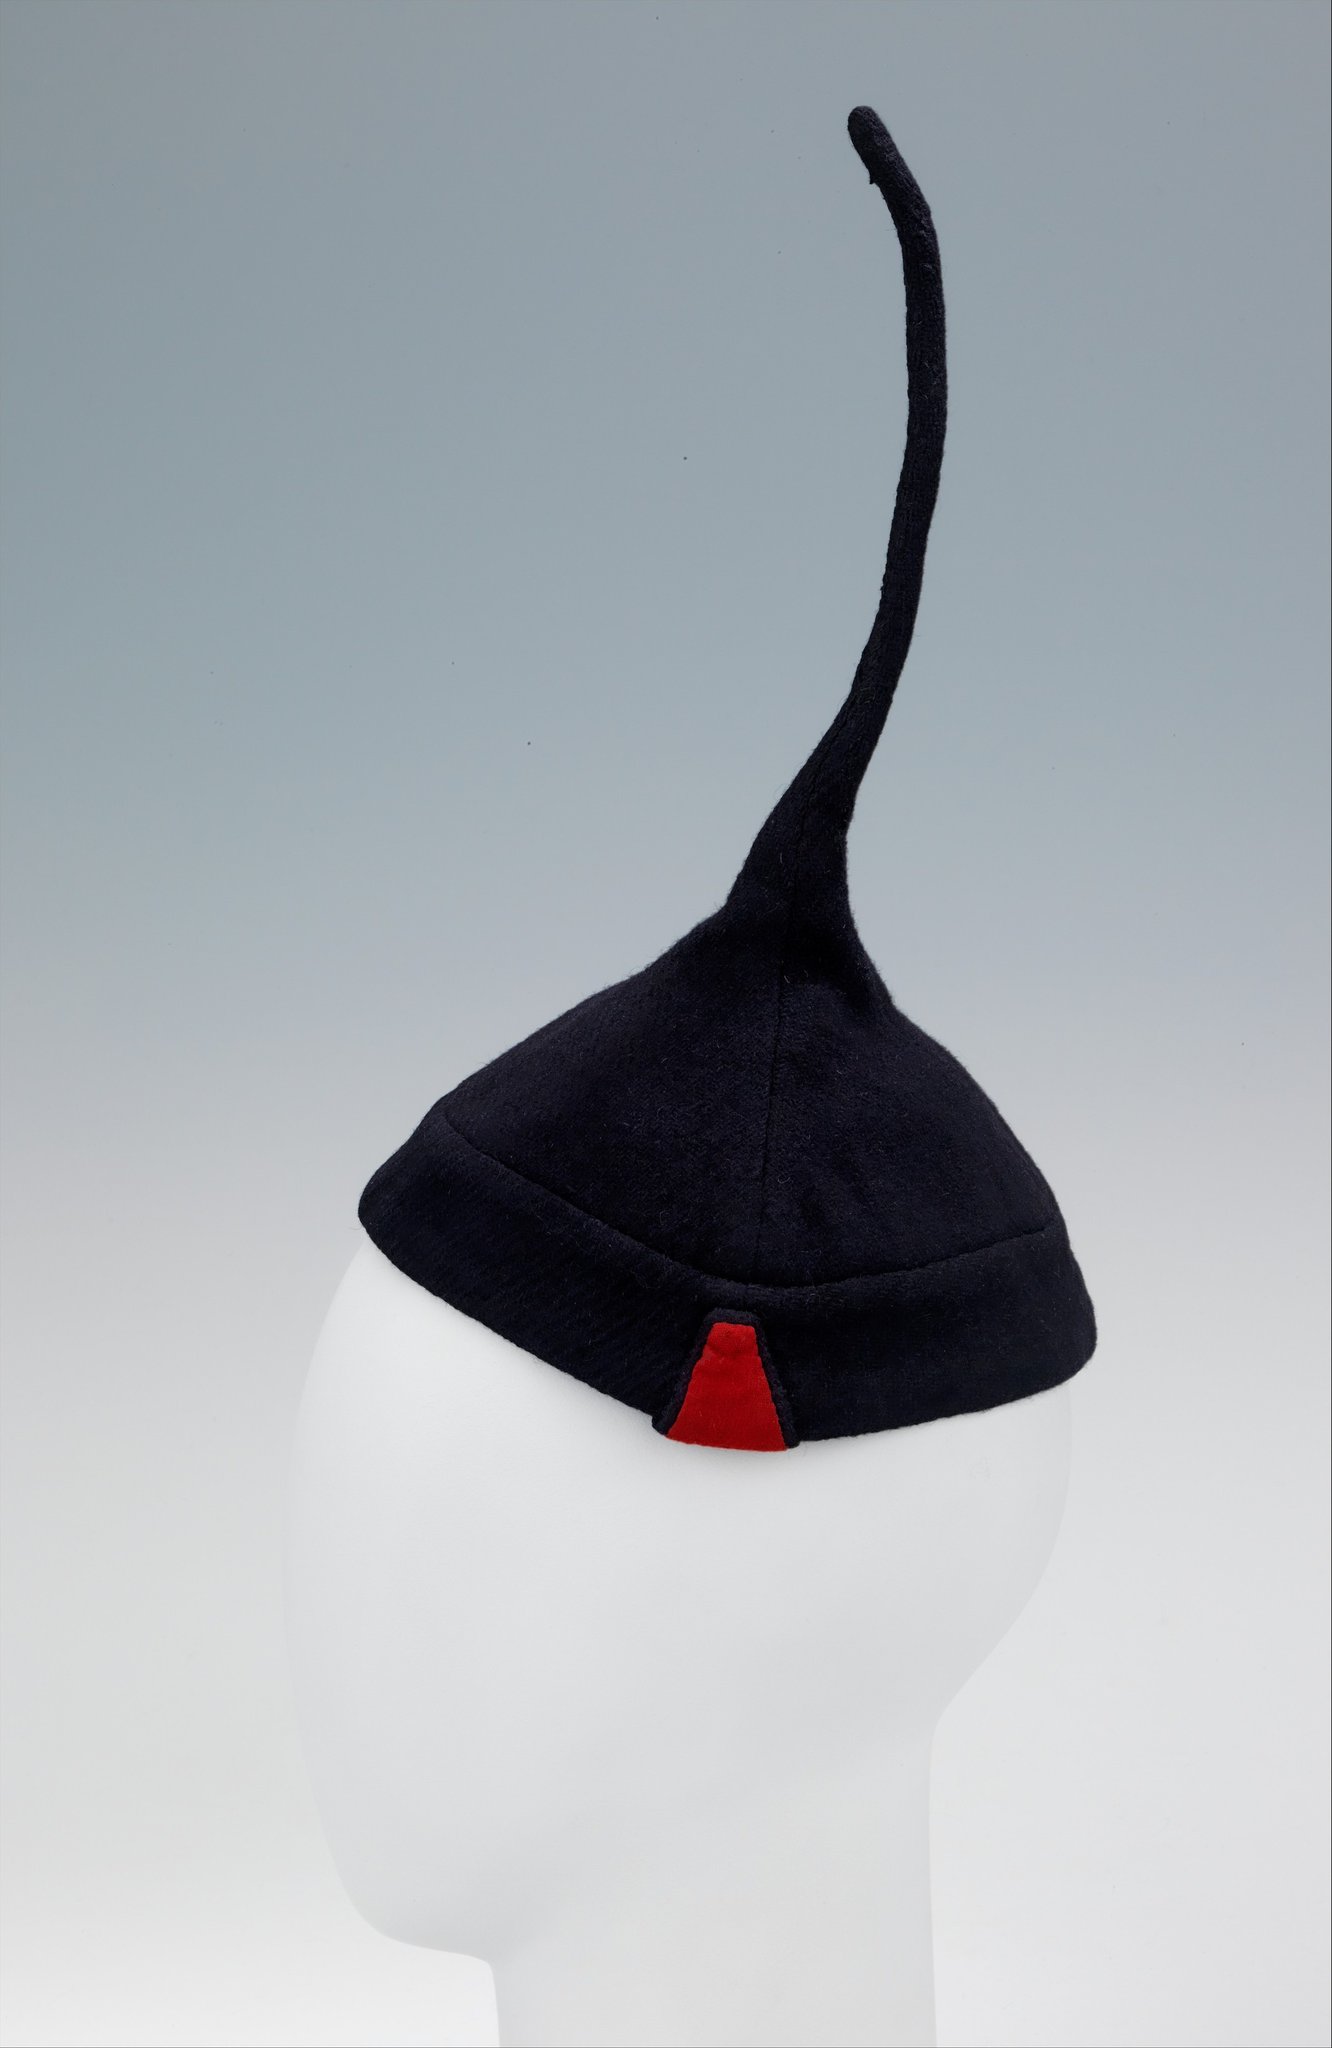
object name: cap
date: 1876-1900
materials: wool